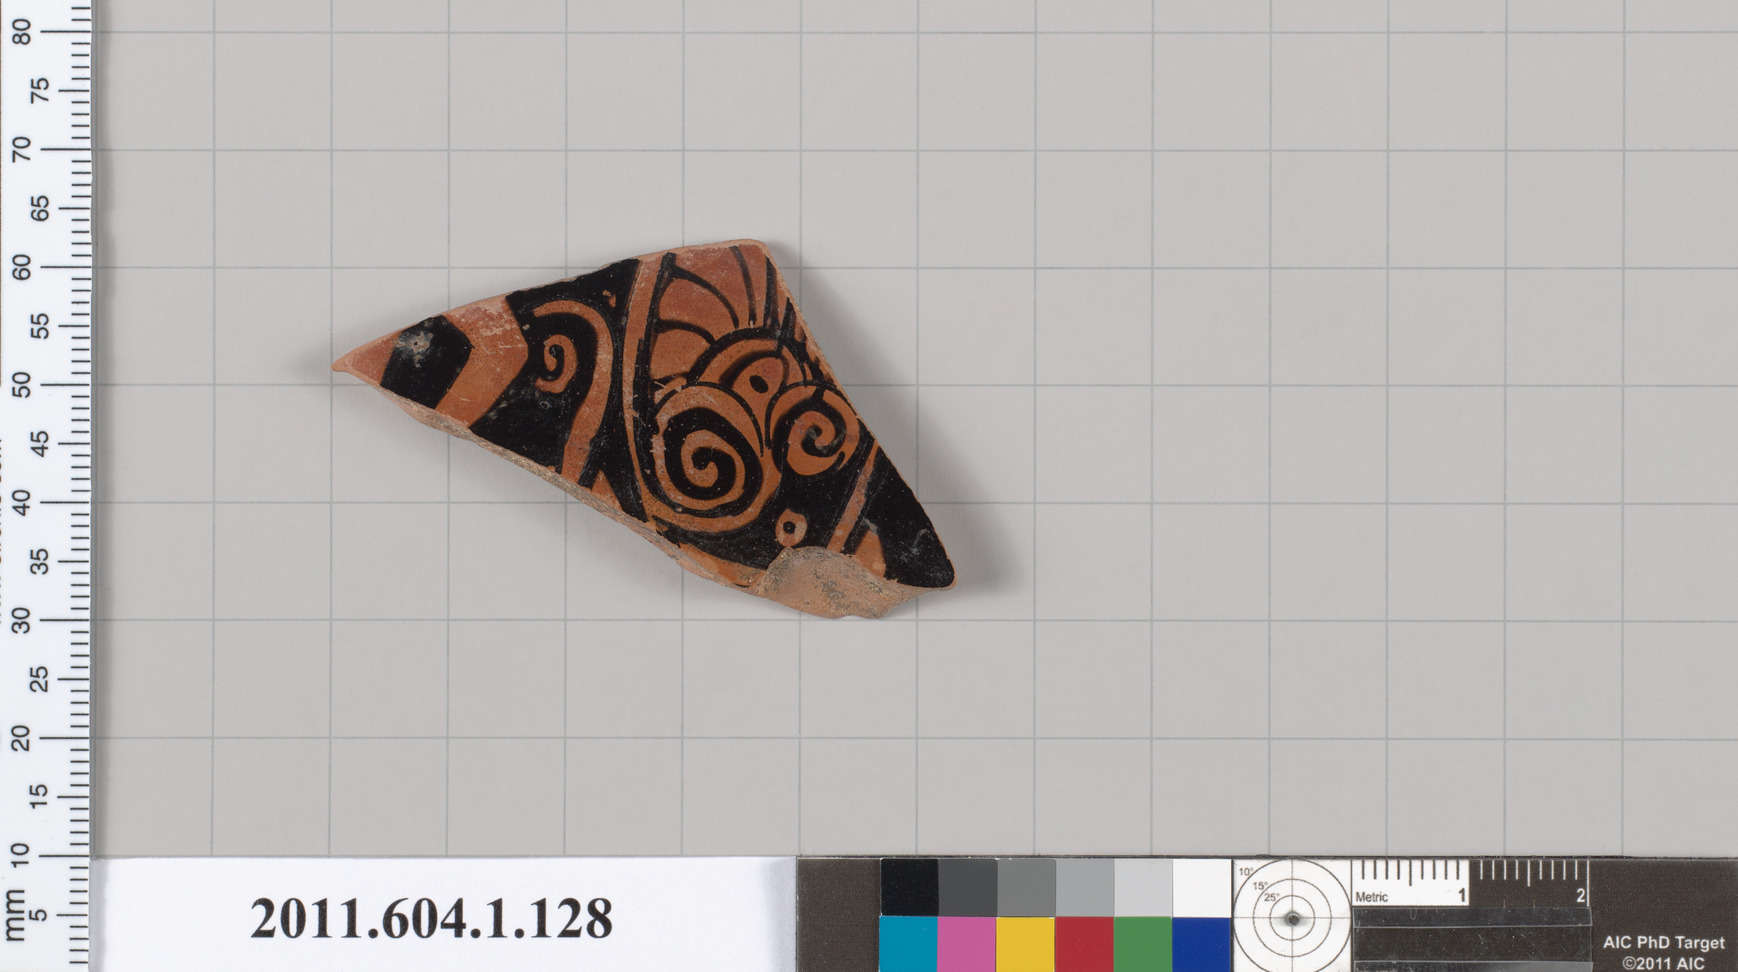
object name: kylix fragment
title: Terracotta fragment of a kylix (drinking cup)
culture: greek, attic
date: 475-451 BCE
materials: terracotta